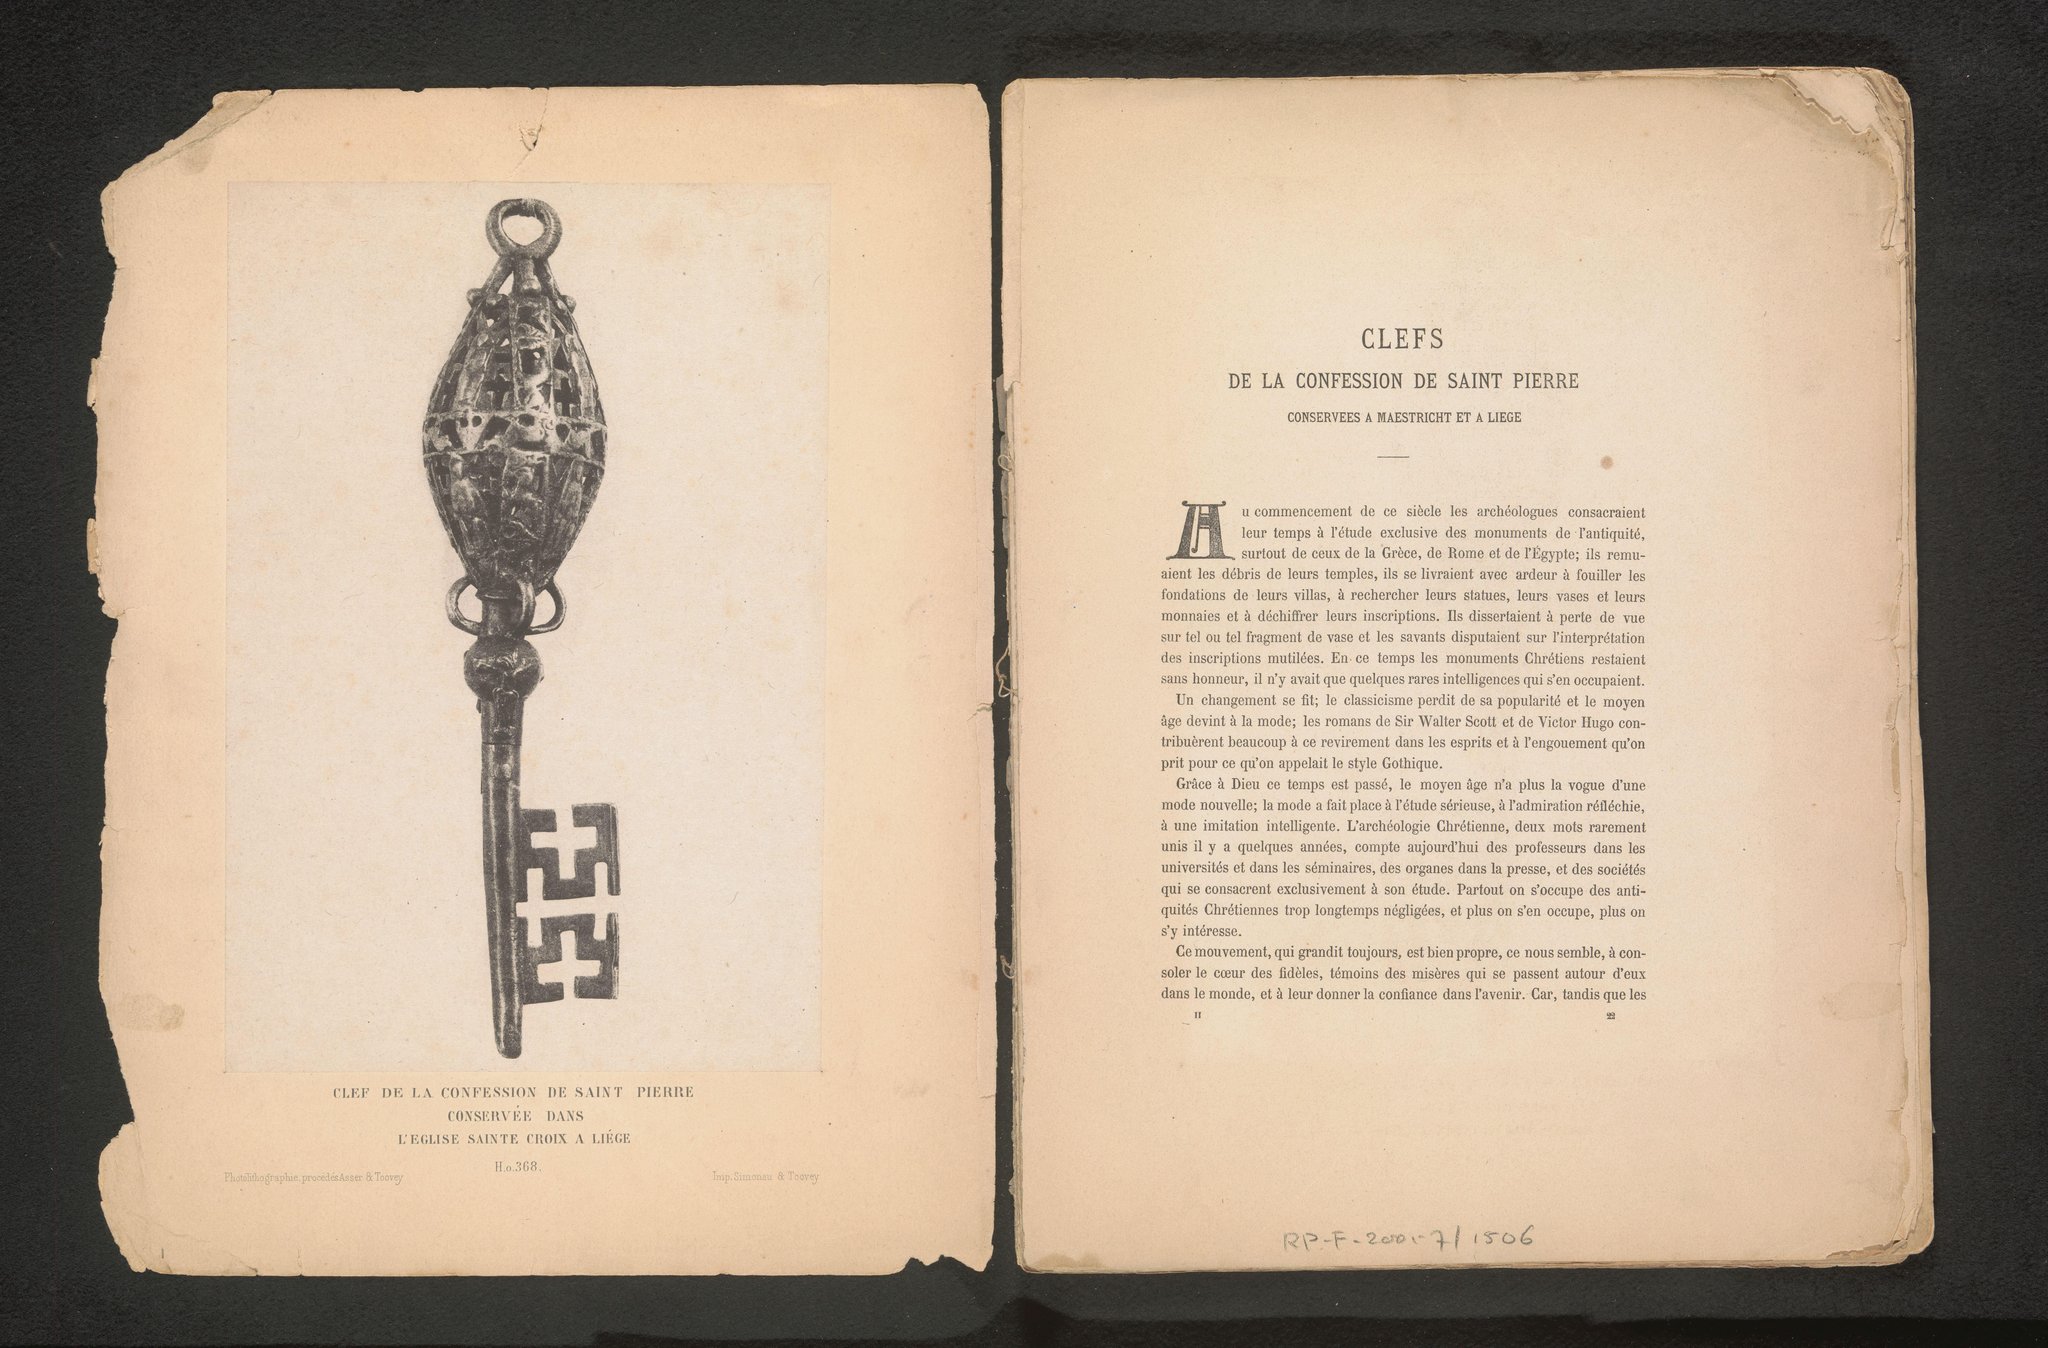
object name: page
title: Clef de la Confession de Saint Pierre conservée dans l'Eglise Sainte Croix à Liége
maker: Anonymous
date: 1860-1865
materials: paper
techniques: photolithography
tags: key, the apostle peter, first bishop of rome; possible attributes: book, cock, (upturned) cross, (triple) crozier, fish, key, scroll, ship, tiara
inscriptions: number: ‘H.o.368.’